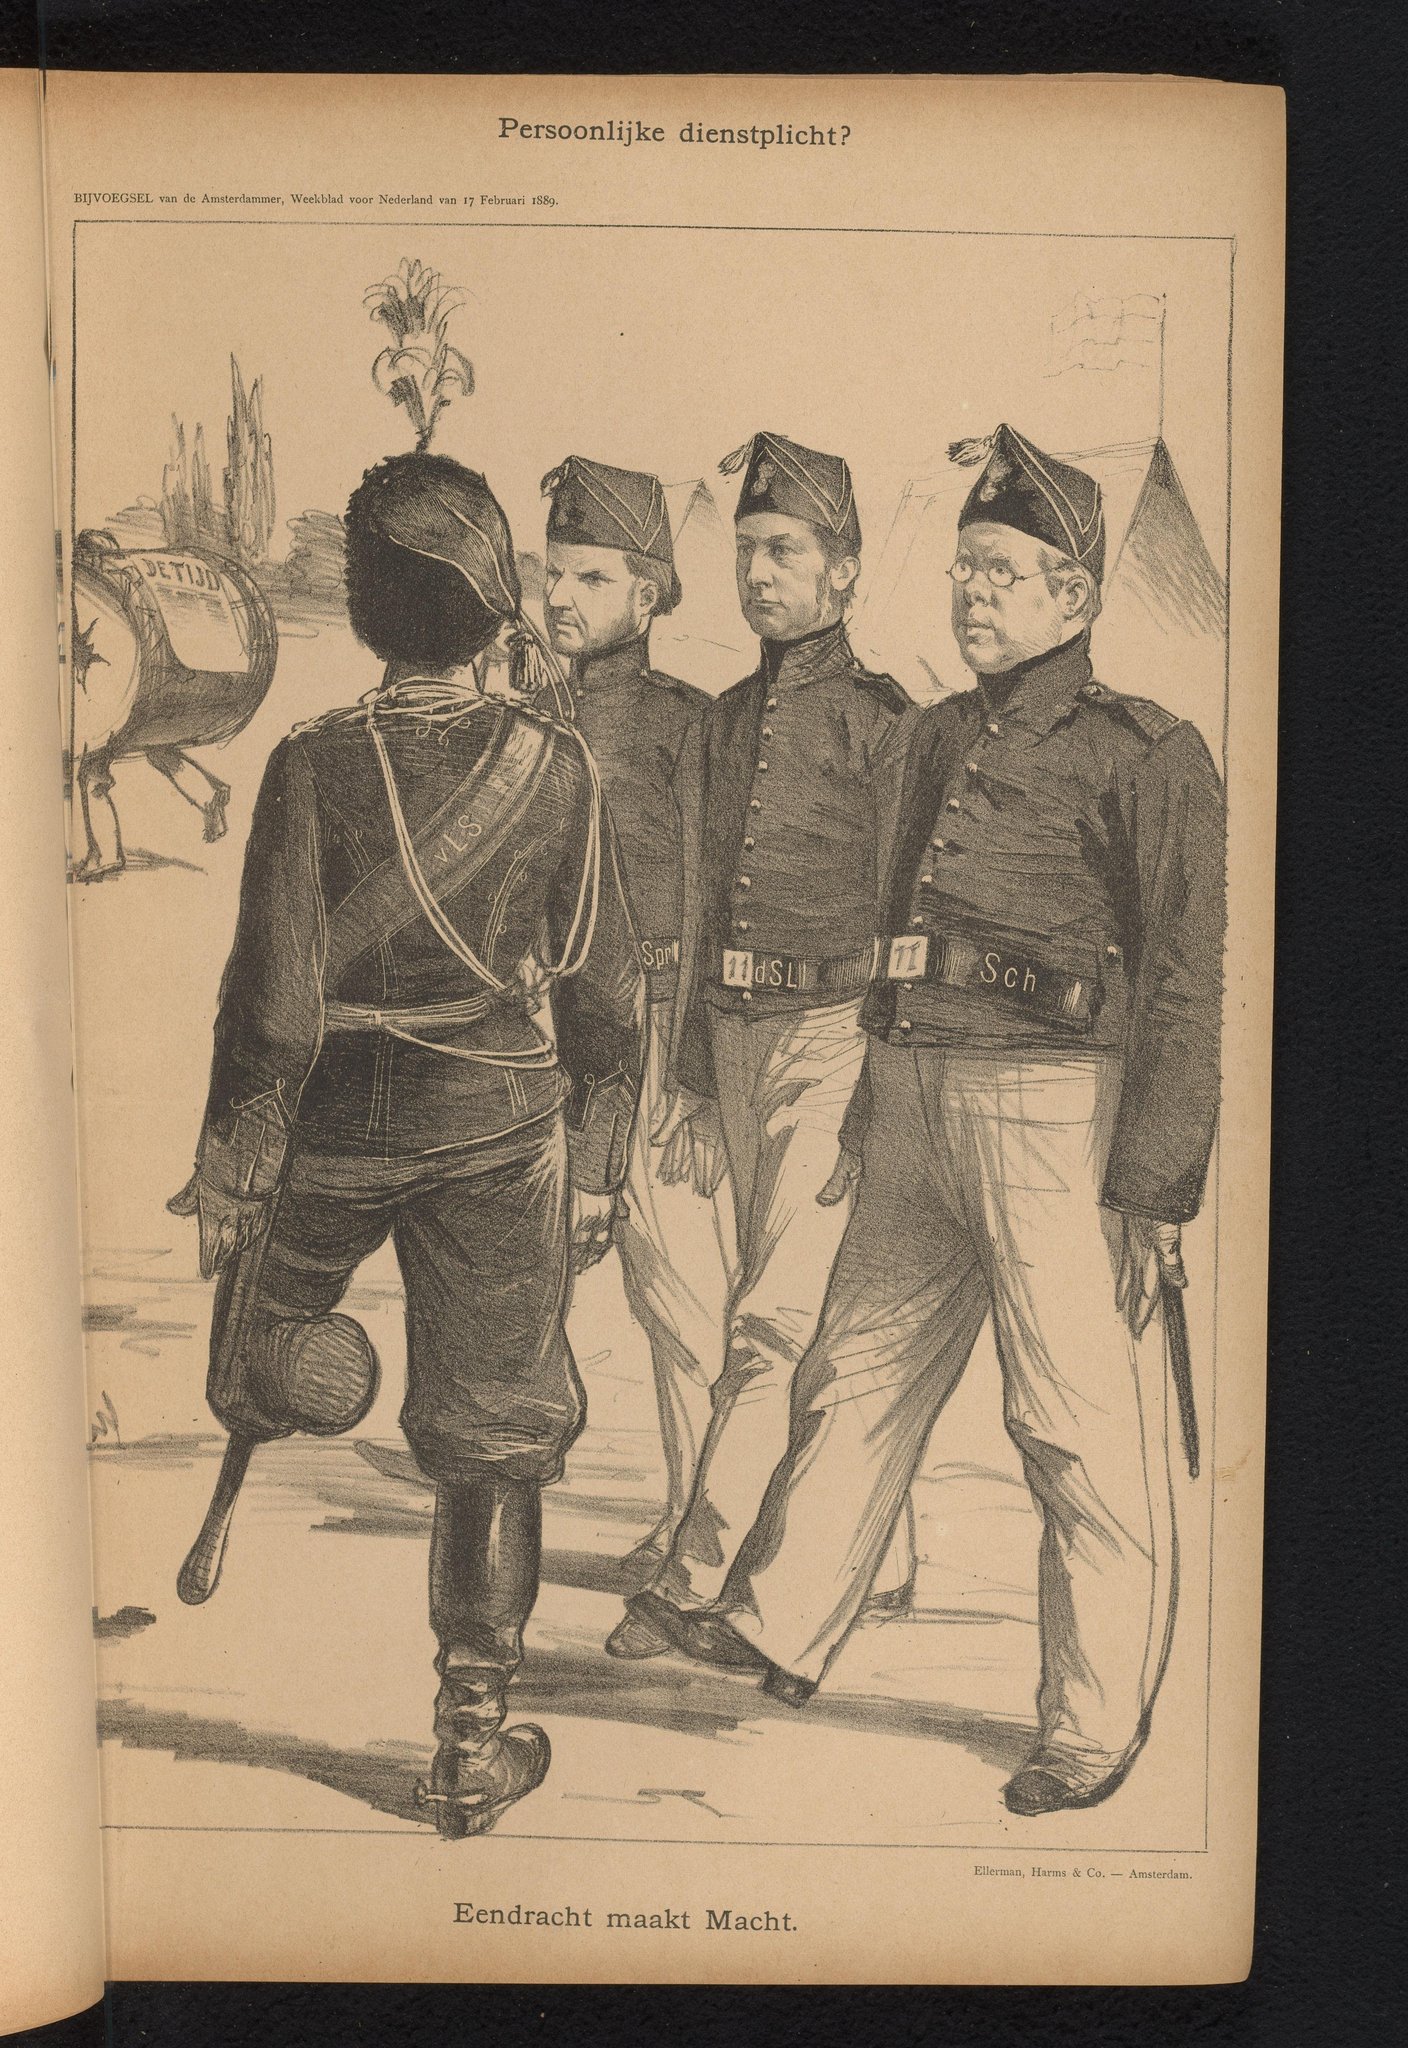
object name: cartoon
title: Persoonlijke dienstplicht? / Eendracht maakt Macht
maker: johan braakensiek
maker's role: draughtsman, print maker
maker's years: 1858-1940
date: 1889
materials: paper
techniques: lithograph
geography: amsterdam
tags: the hague, jonkheer alexander frederik de savornin lohman, rome, priest, herman johannes aloysius maria schaepman, military service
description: Spotprent op de invoering van de persoonlijke dienstplicht, ter vervanging van de conscriptie waarbij geloot werd. Drie dienstplichtigen waaronder de politici Schaepman en De Savornin Lohman.